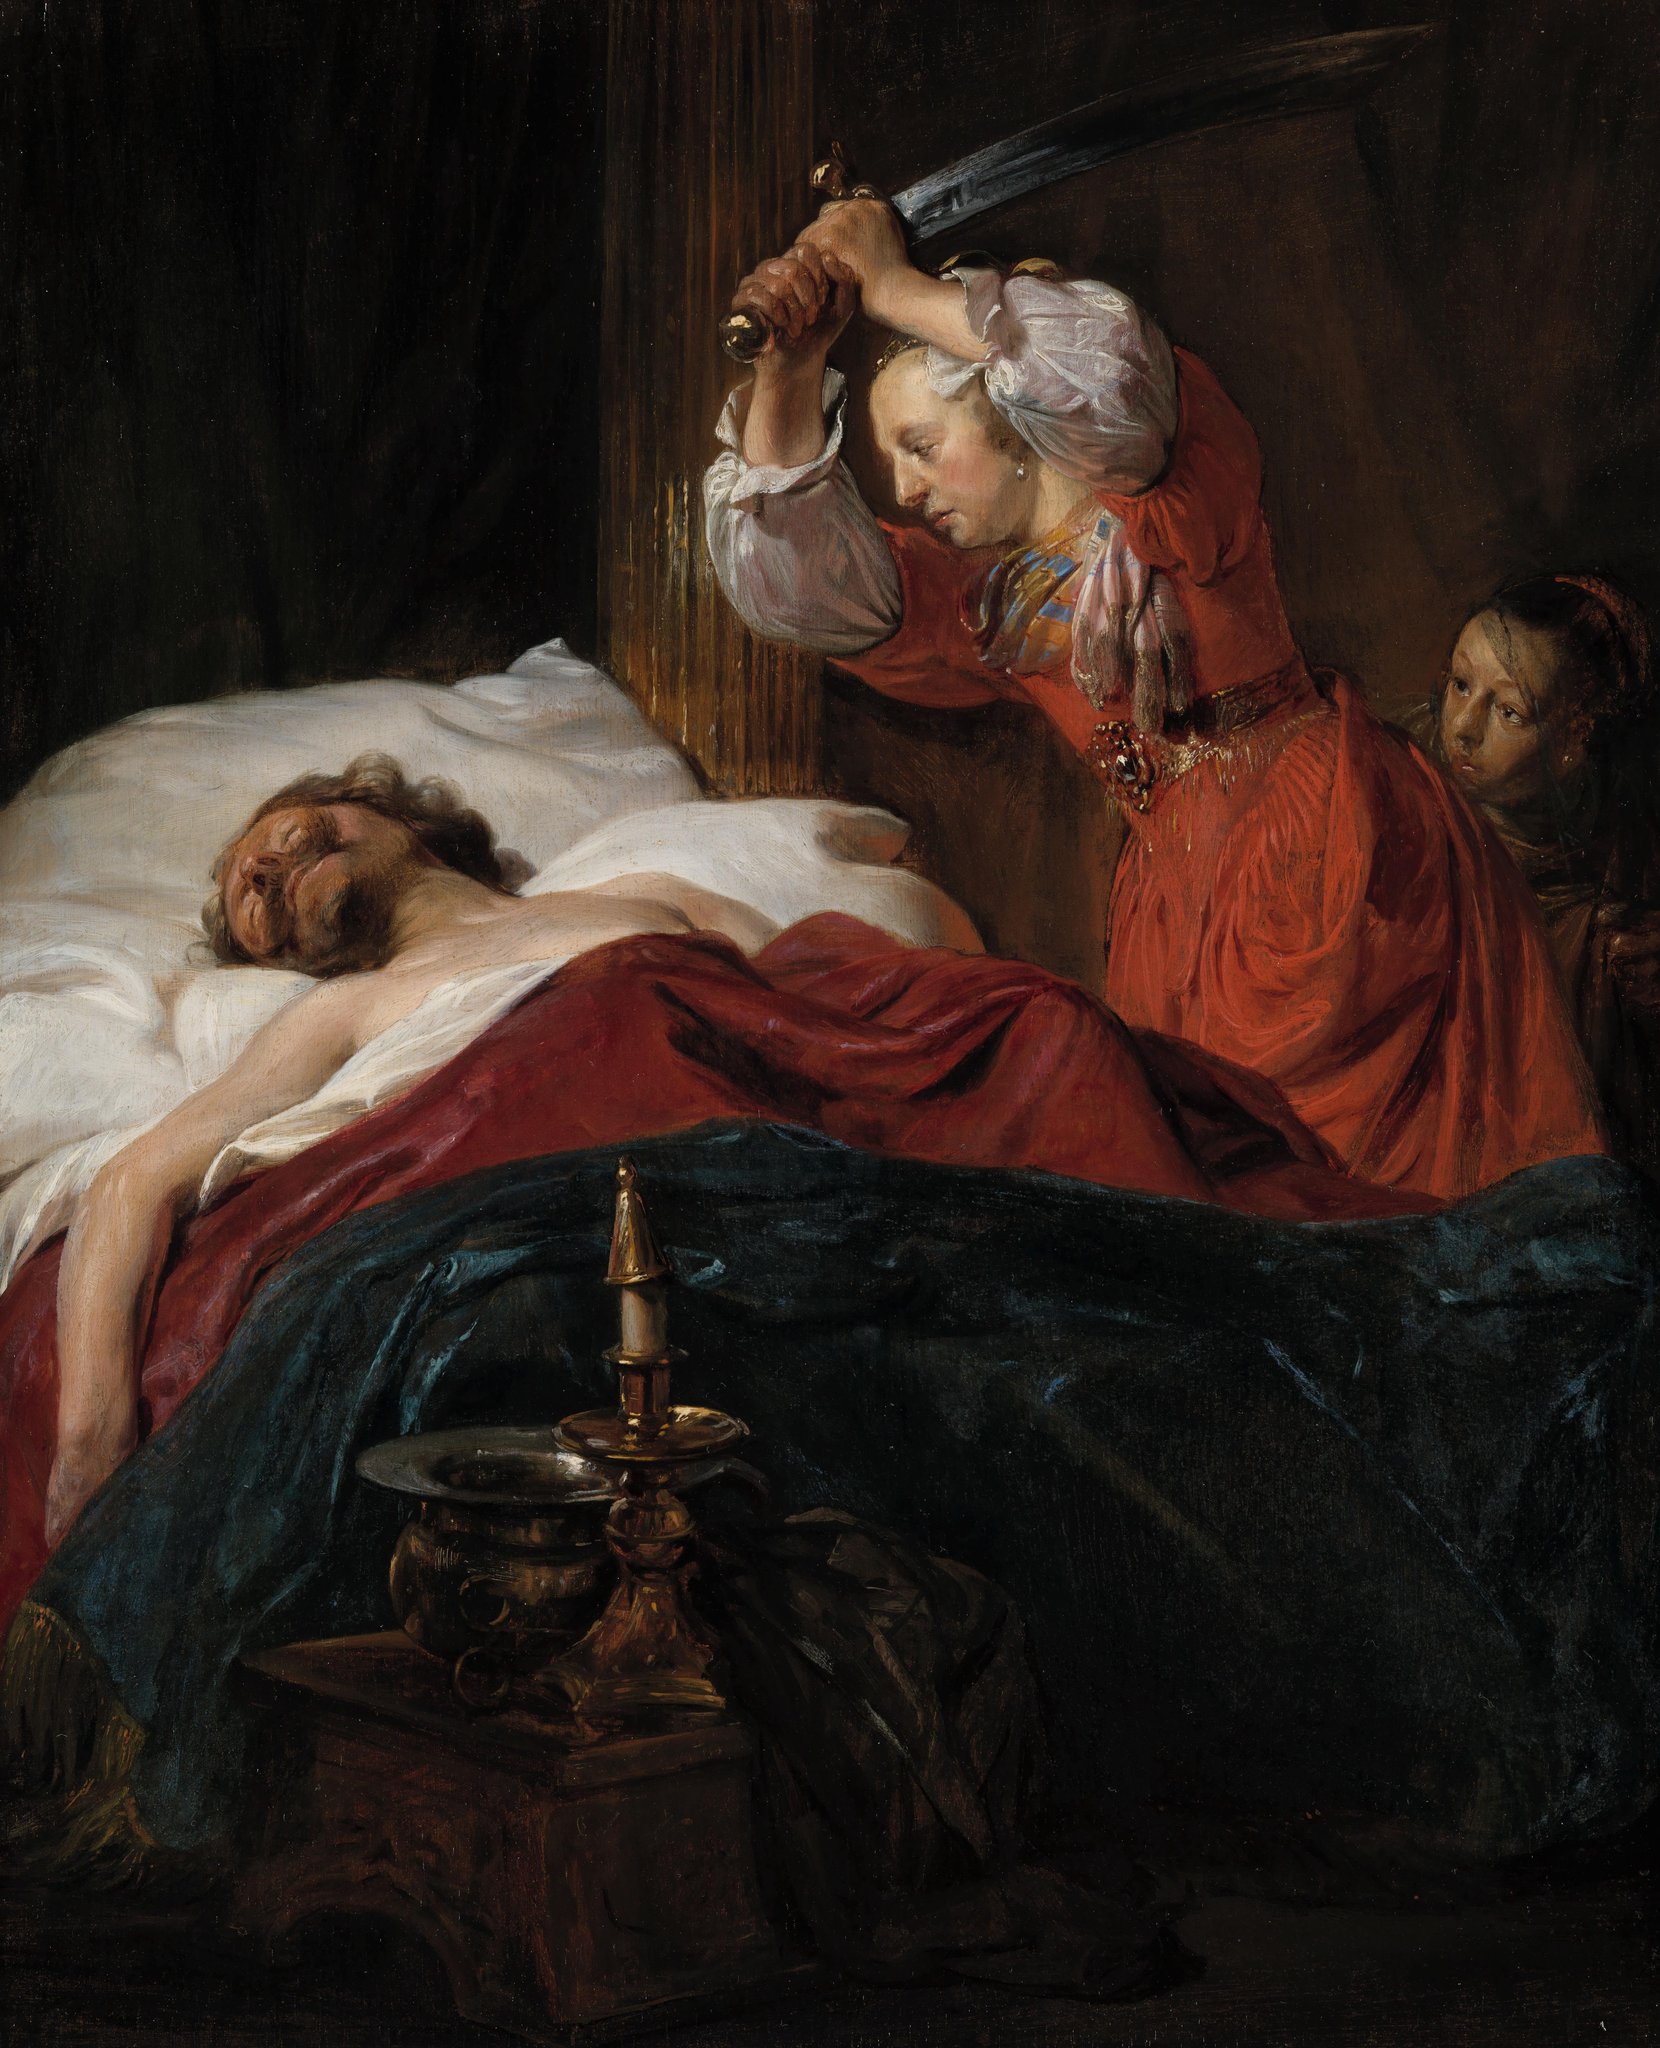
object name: painting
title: Judith and Holofernes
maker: jan de bray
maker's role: draughtsman, print maker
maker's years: 1627-1697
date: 1659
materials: oil, panel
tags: holofernes drinks too much, and falls asleep on the bed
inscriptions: signature and date: ‘Bray 1659’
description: Judith en Holofernes. Judith staat met geheven zwaard op het punt om het hoofd van de slapende Holofernes af te slaan, rechts haar dienstmaagd. Links op de voorgrond een tafeltje waarop een kandelaar en een koperen pot.